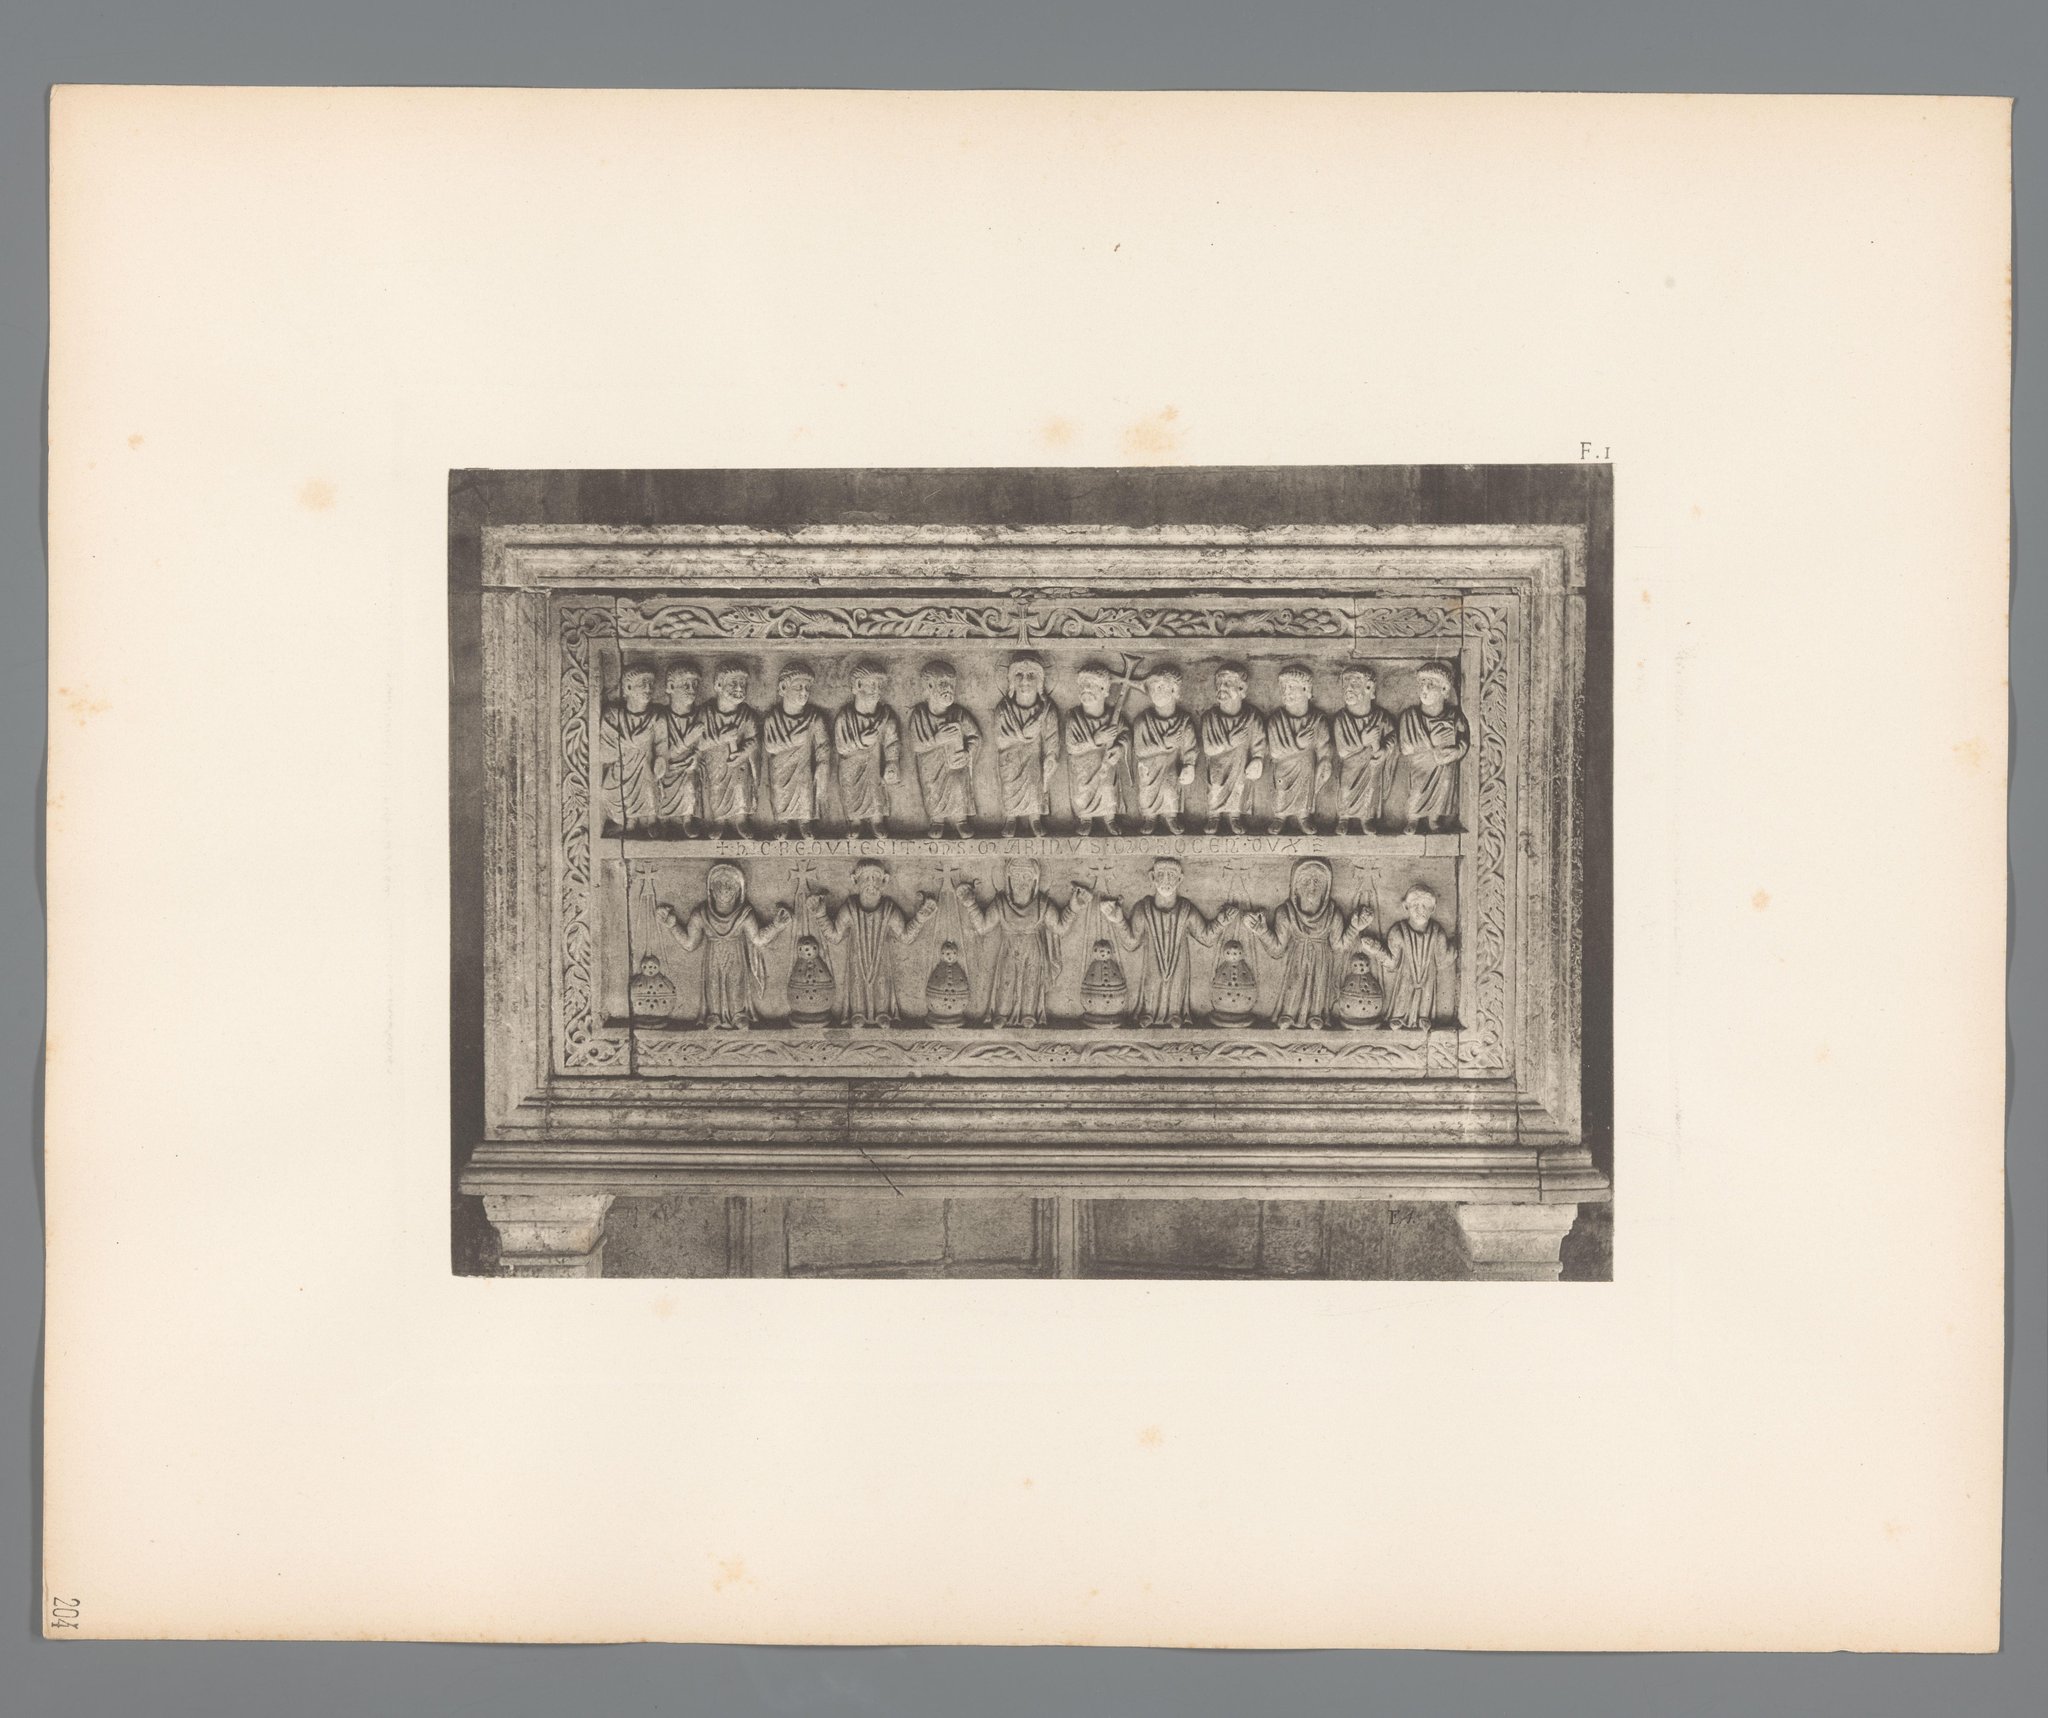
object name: photomechanical print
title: Reliëf van Christus en de twaalf apostelen van de San Marco in Venetië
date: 1880-1885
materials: paper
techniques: photograph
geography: venice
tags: the twelve apostles (as a group), usually with books or scrolls (not in biblical context) (+ christ), piece of sculpture, reproduction of a piece of sculpture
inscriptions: number: ‘204’, number: ‘F.I’, number: ‘F.1.’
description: Deze prent maakt deel uit van een omslag met 79 prenten op 53 bladen en 2 tekstbladen.